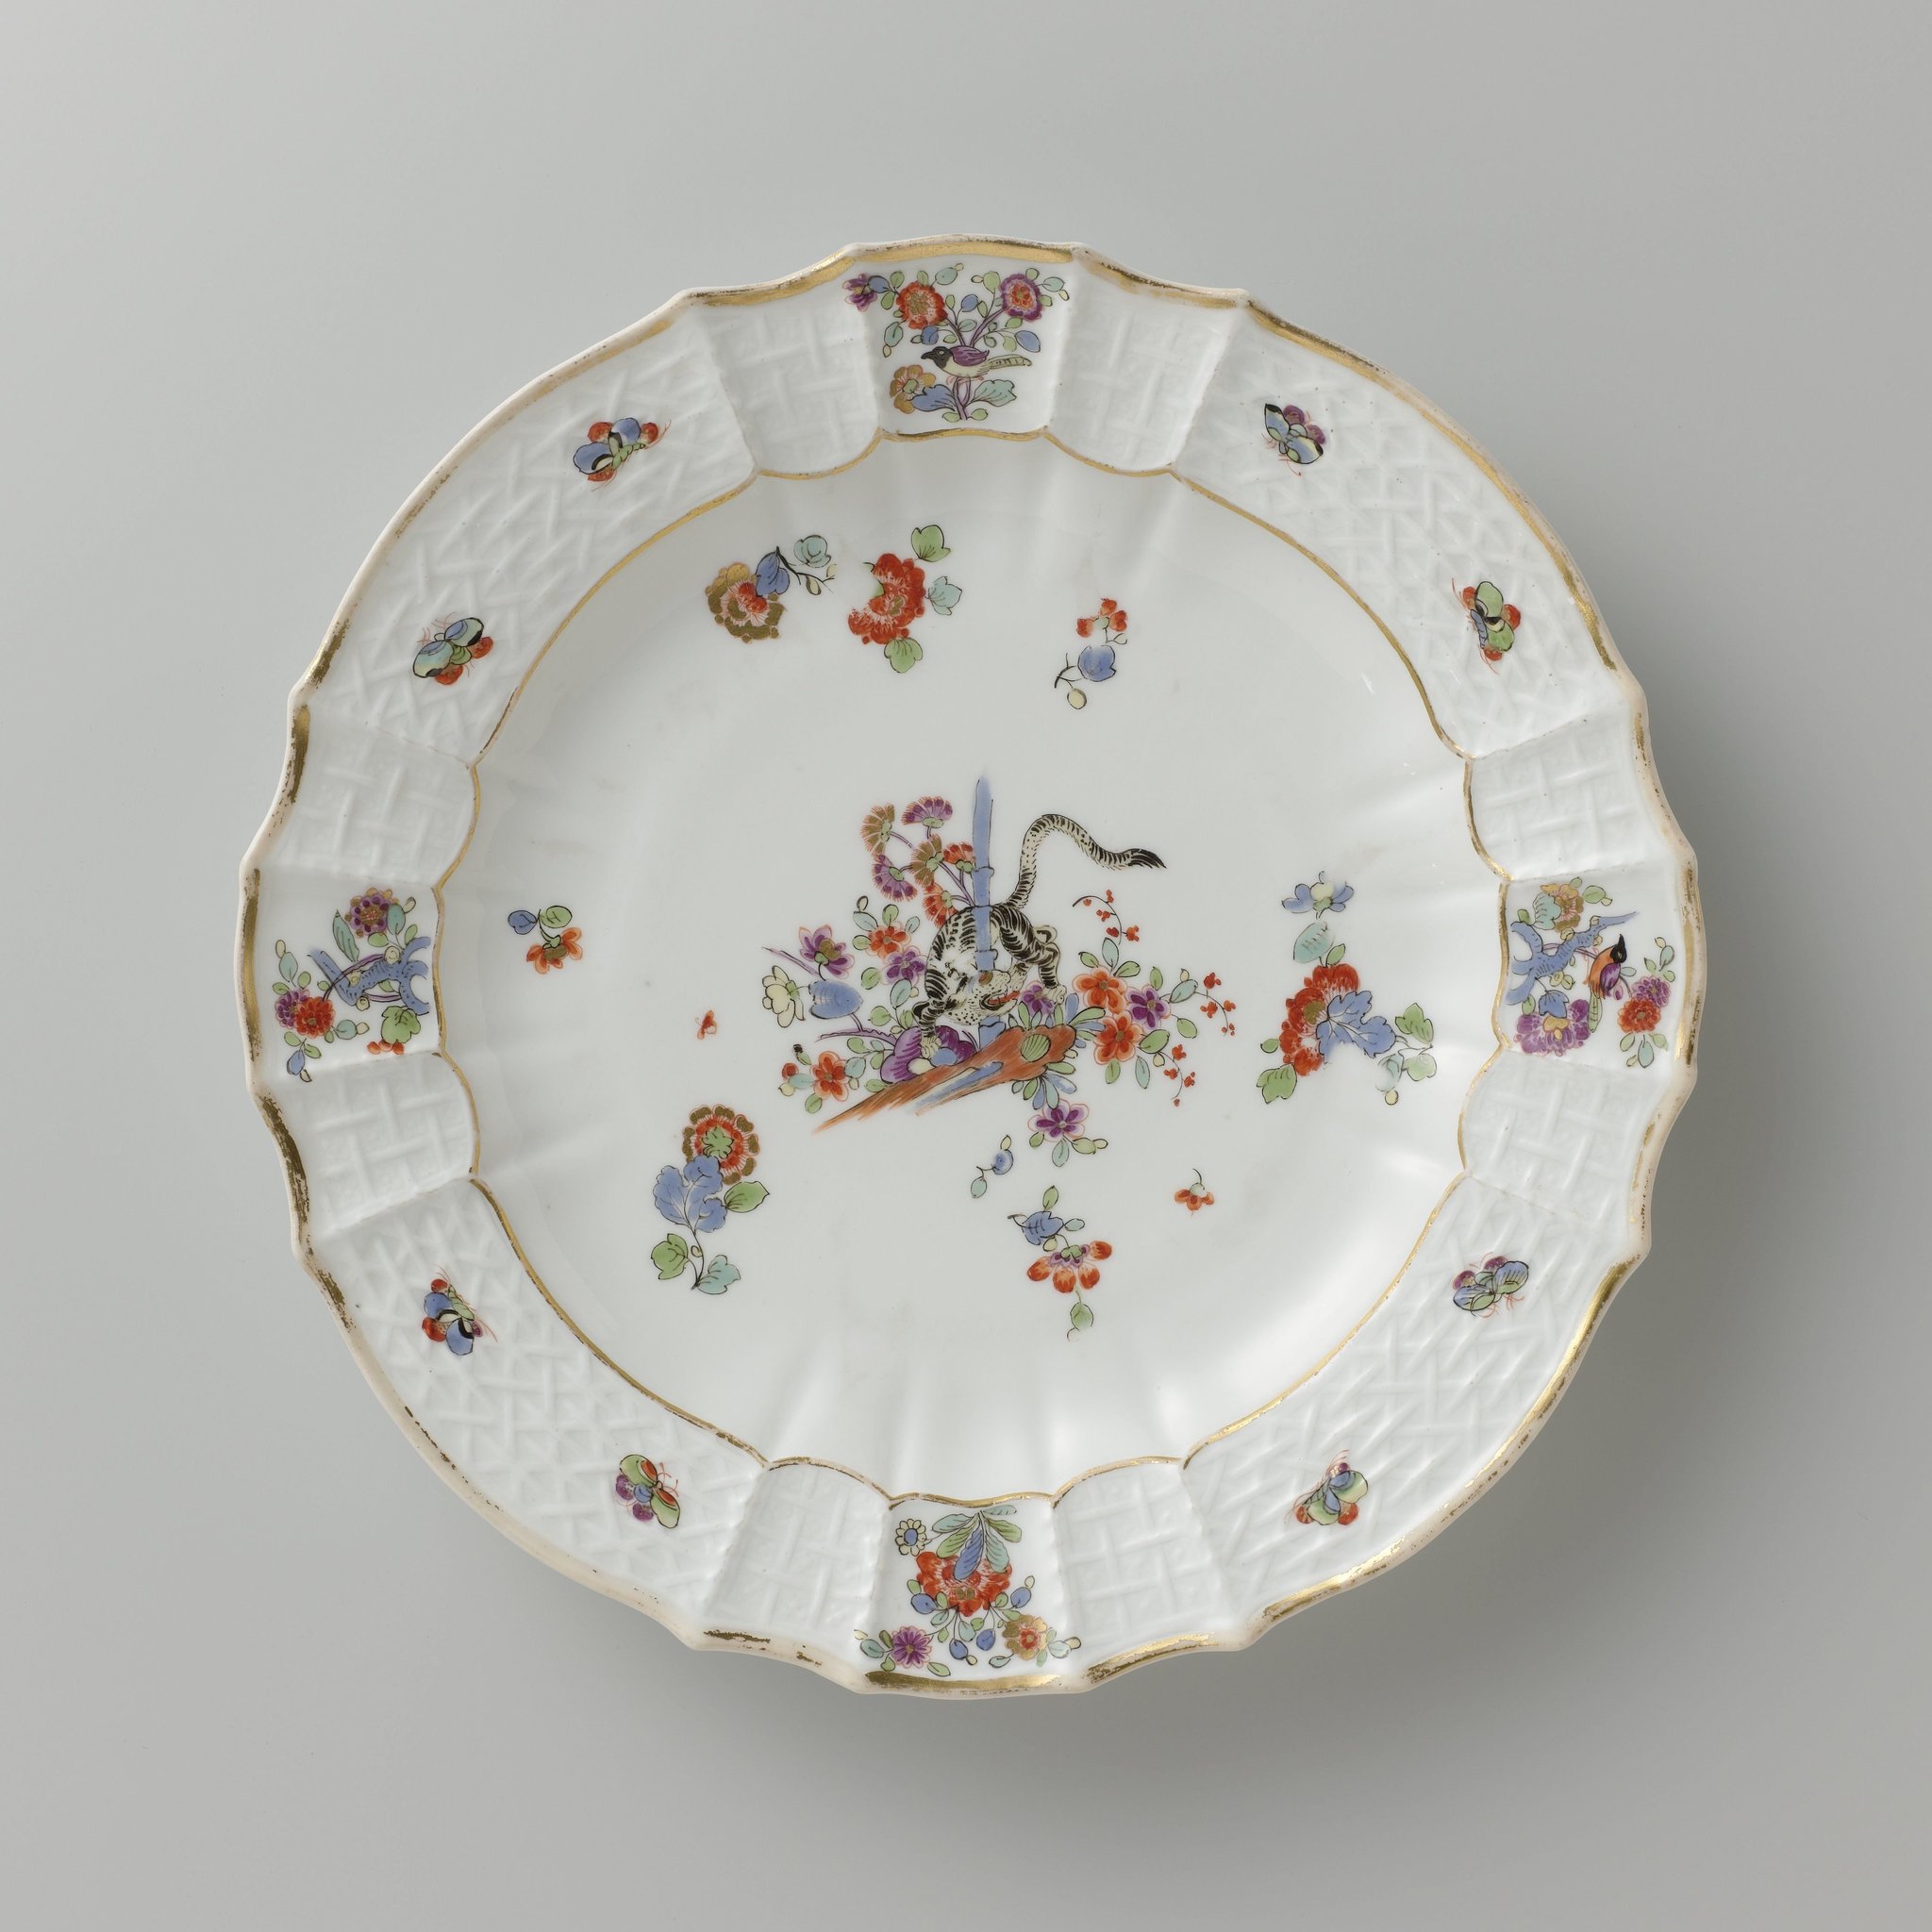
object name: plate dish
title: Rond bord, veelkleurig beschilderd met een Kakiemon-decor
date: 1740-1745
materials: porcelain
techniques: painted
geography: meissen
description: Rond bord van beschilderd porselein. Het bord is geribd en heeft een geschulpte rand. Het bord is beschilderd met een tijger die om een blauwe bamboestengel tussen bloemen is gedraaid, gestrooide Indianische Blumen, vlinders en takken waarop vogels. De rand is versierd met het 'Altbrandenstein'-patroon. Het bord is gemerkt.